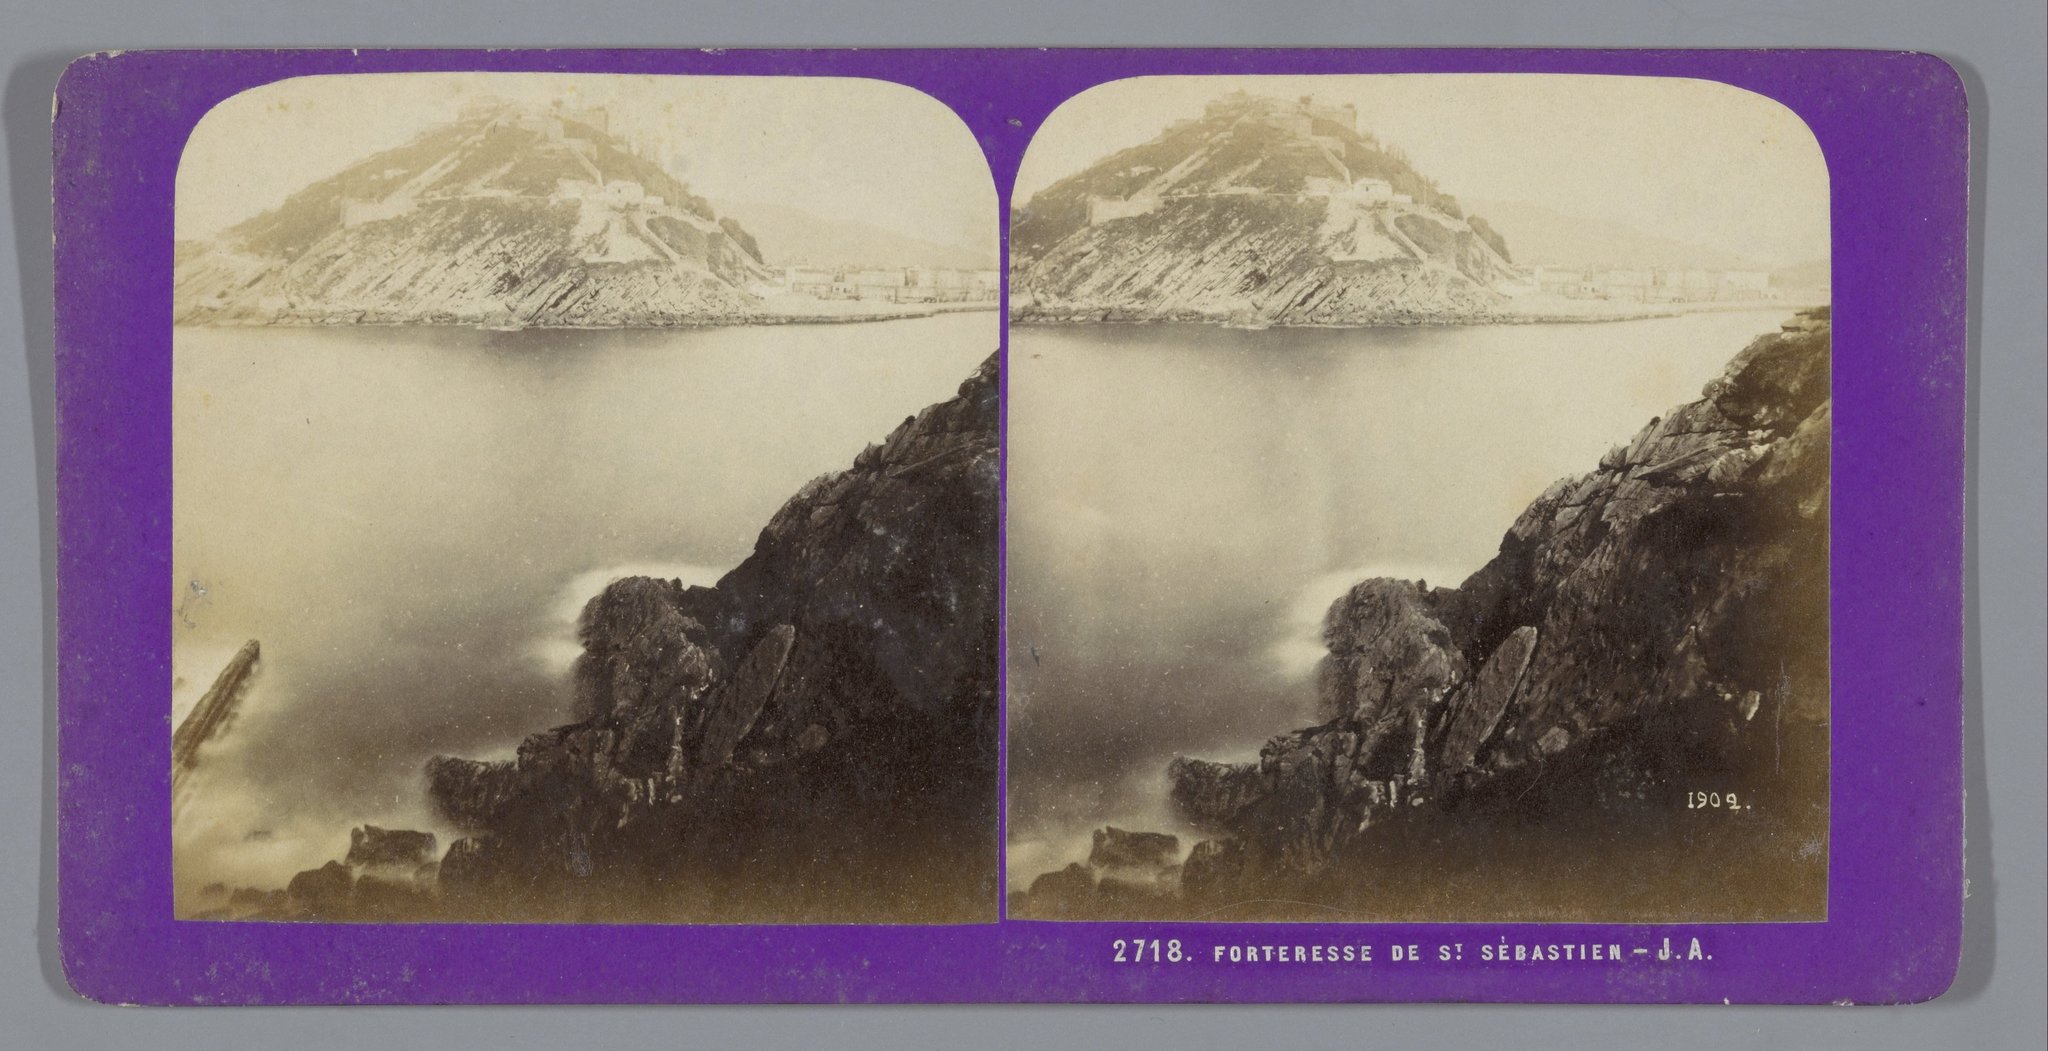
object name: stereograph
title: FORTERESSE DE St. SÉBASTIEN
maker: jean andrieu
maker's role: fotograaf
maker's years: 1816-1872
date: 1862-1876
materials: cardboard, photographic support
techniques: albumen print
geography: donostia-san sebastián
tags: gulf, bay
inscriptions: number: ‘1902.’, number: ‘2718.’